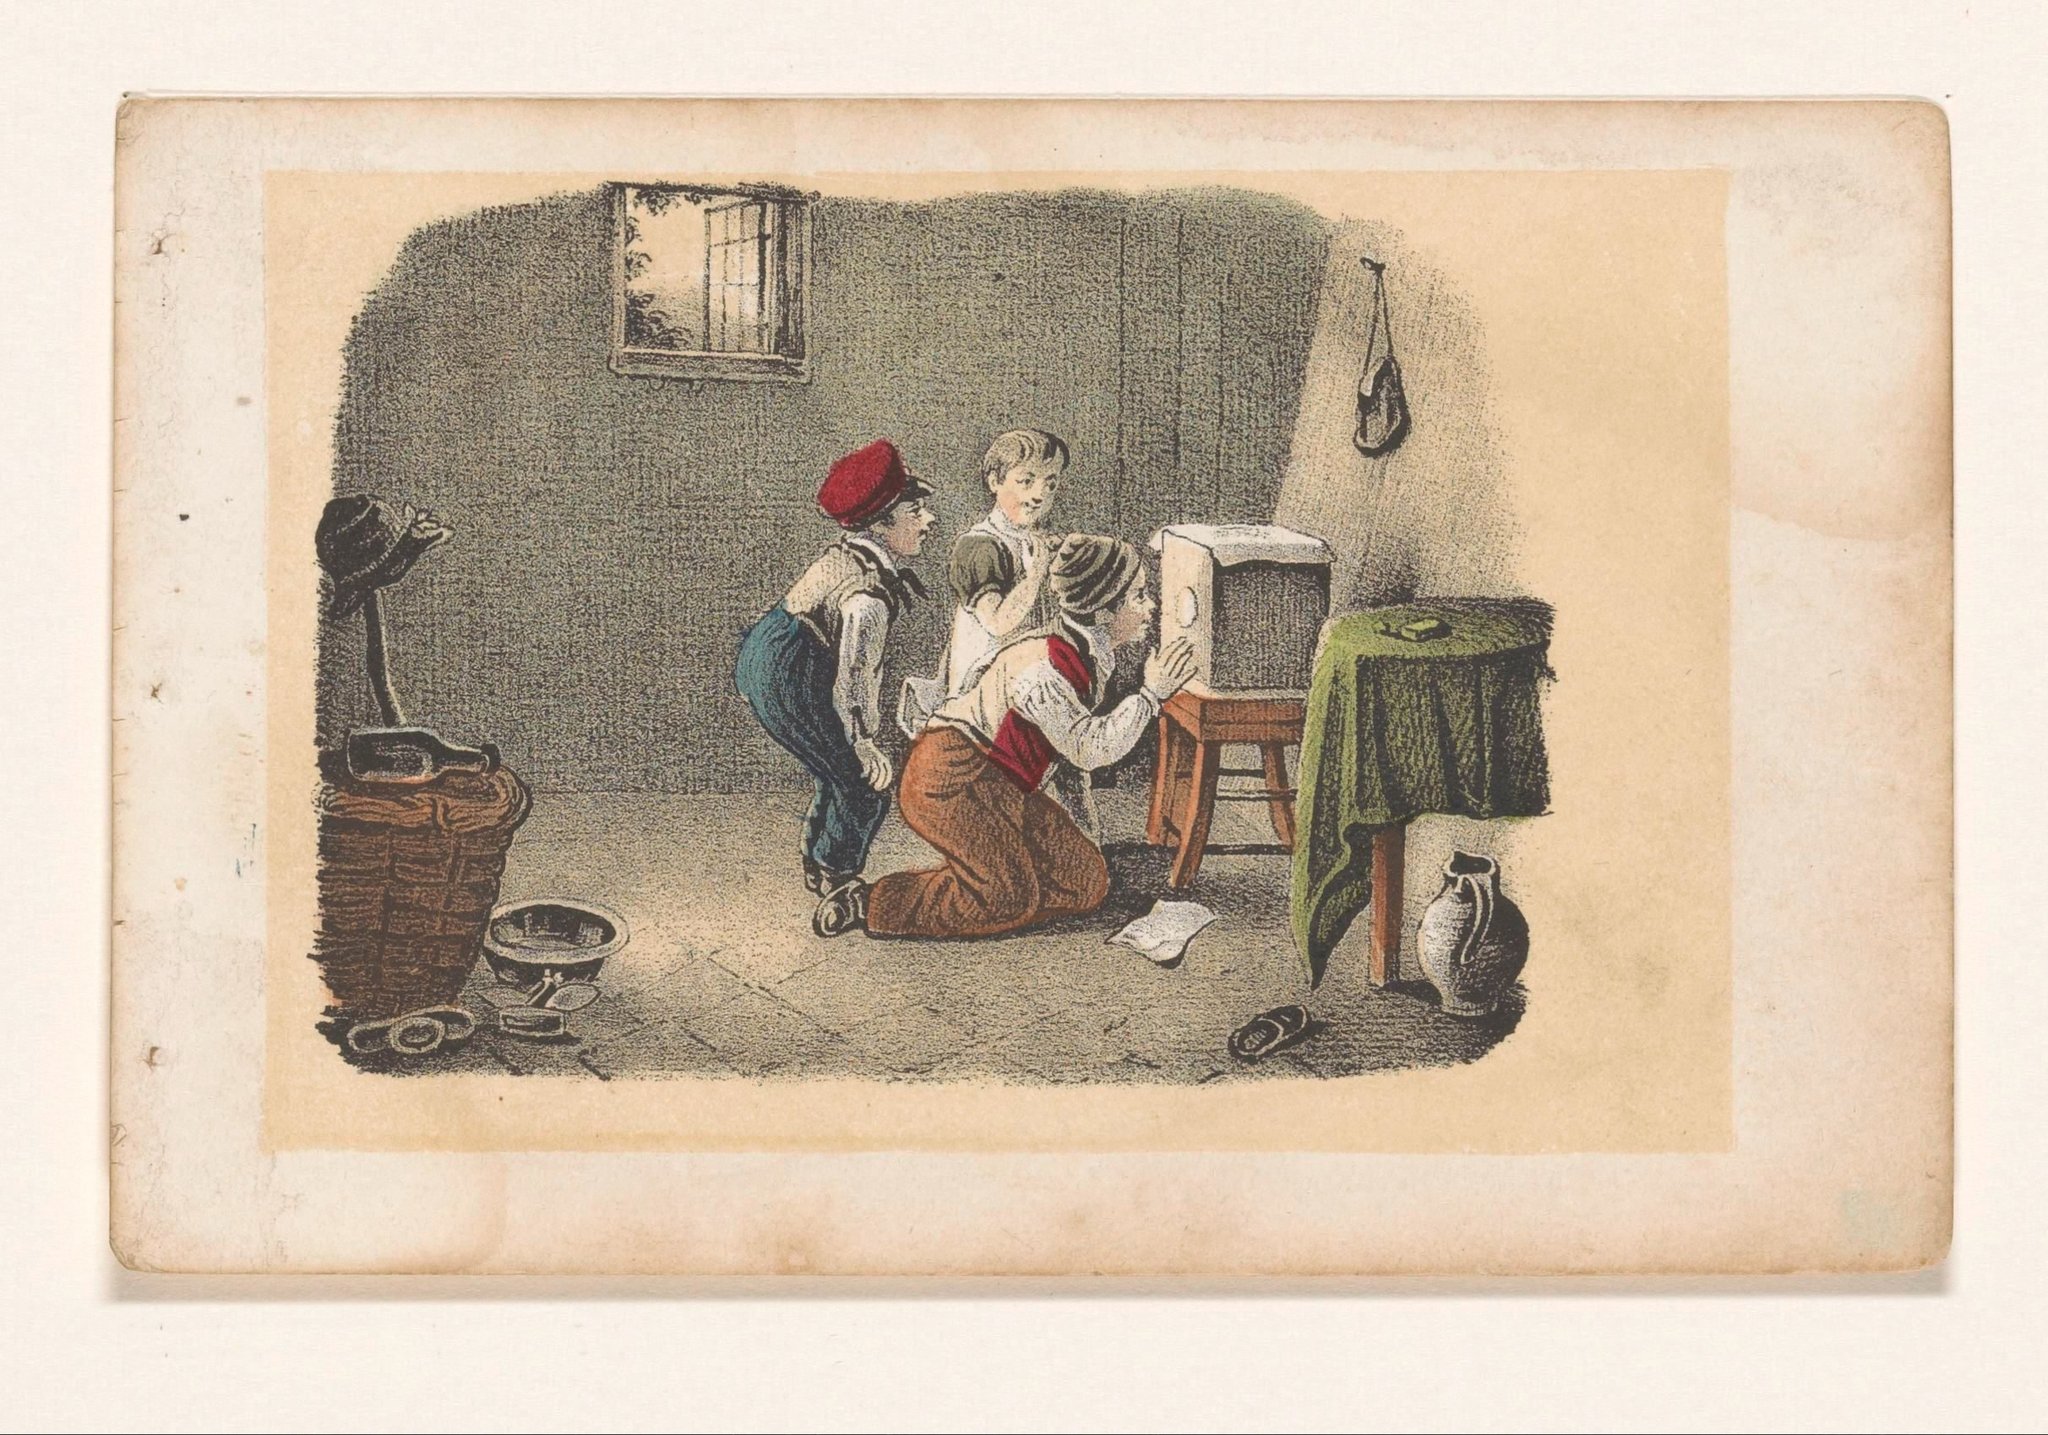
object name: book illustration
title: Interieur met drie kinderen rond een kijkkast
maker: Anonymous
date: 1809-1899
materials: paper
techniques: hand coloring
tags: peep-show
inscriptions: collector's mark: Lugt 2228, collector's mark: Lugt 4780, collector's mark: Lugt 4779